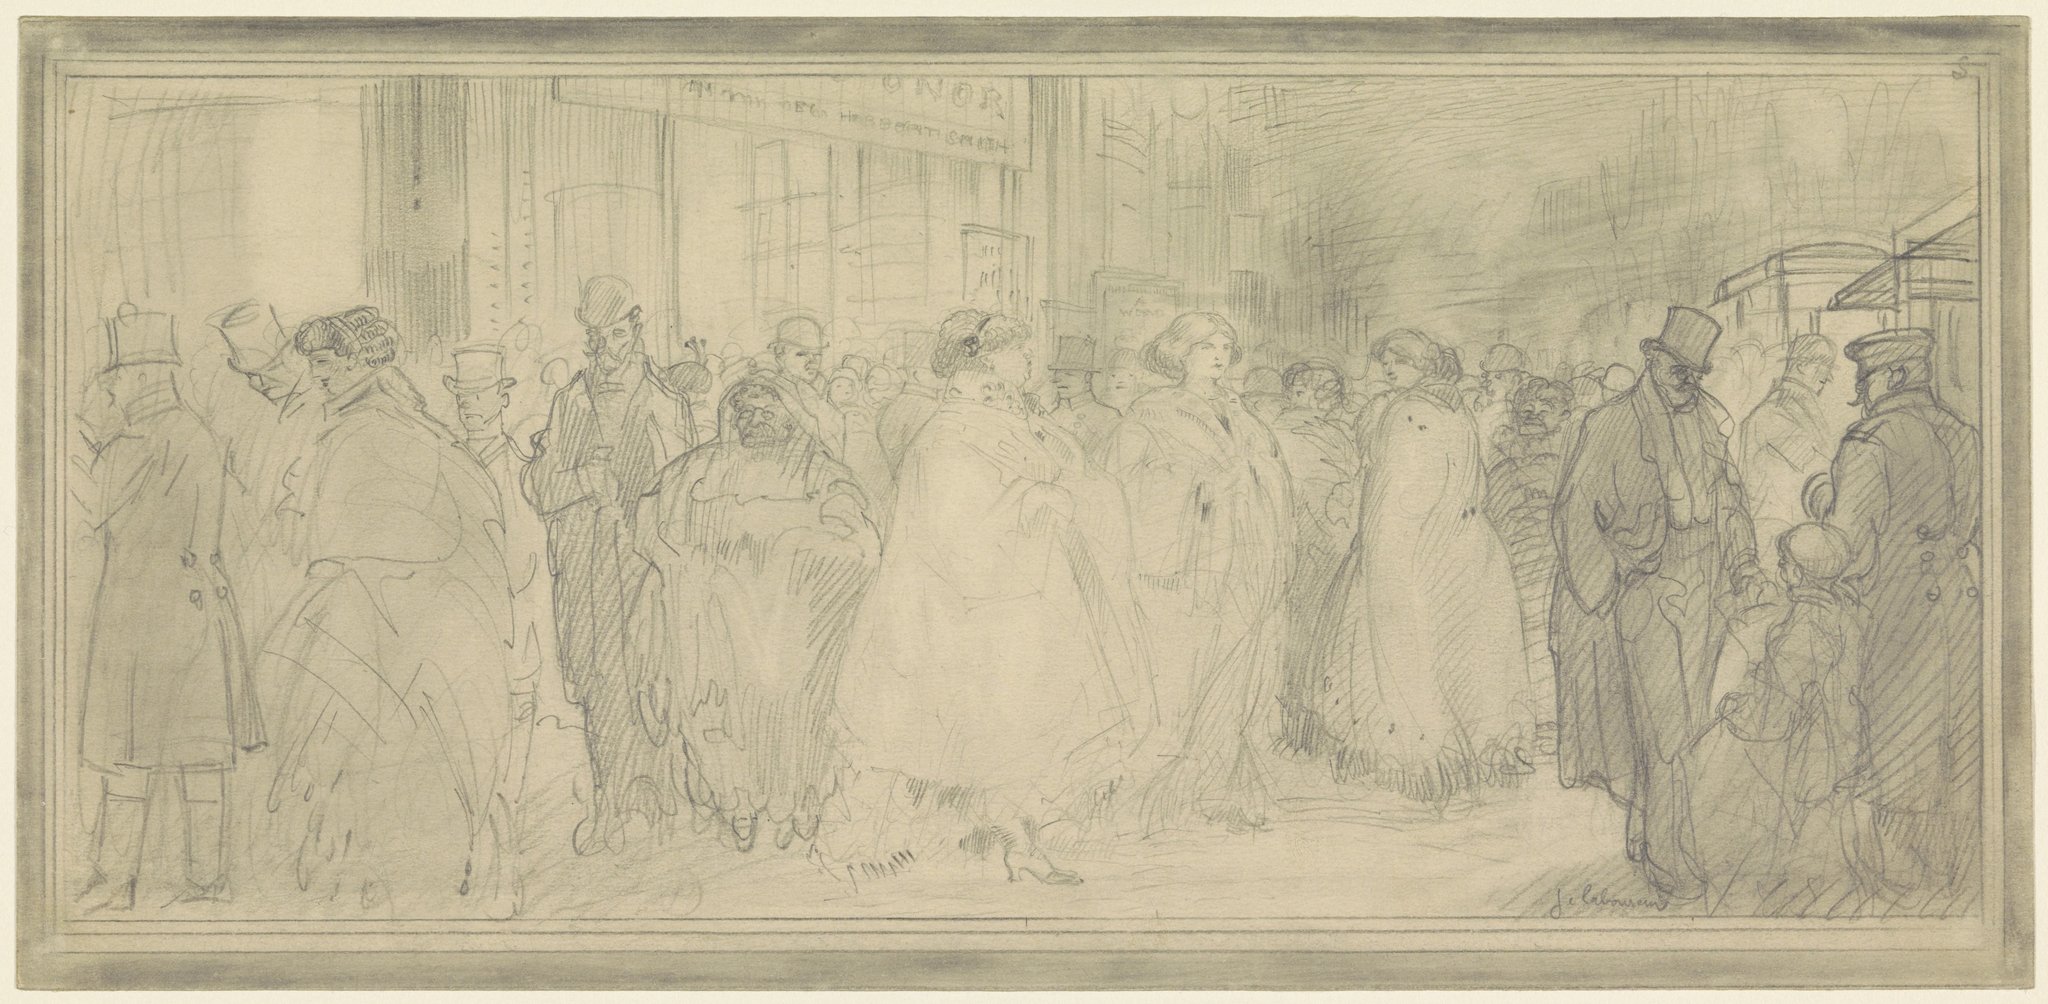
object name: design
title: Straattafereel bij het uitgaan van een theater te Londen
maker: jean emile laboureur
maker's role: draughtsman, print maker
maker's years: 1877-1943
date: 1887-1943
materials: paper, pencil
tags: theatre (building), the audience ~ art performance, london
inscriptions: inscription: ‘Sortie de théâtre à Londres’